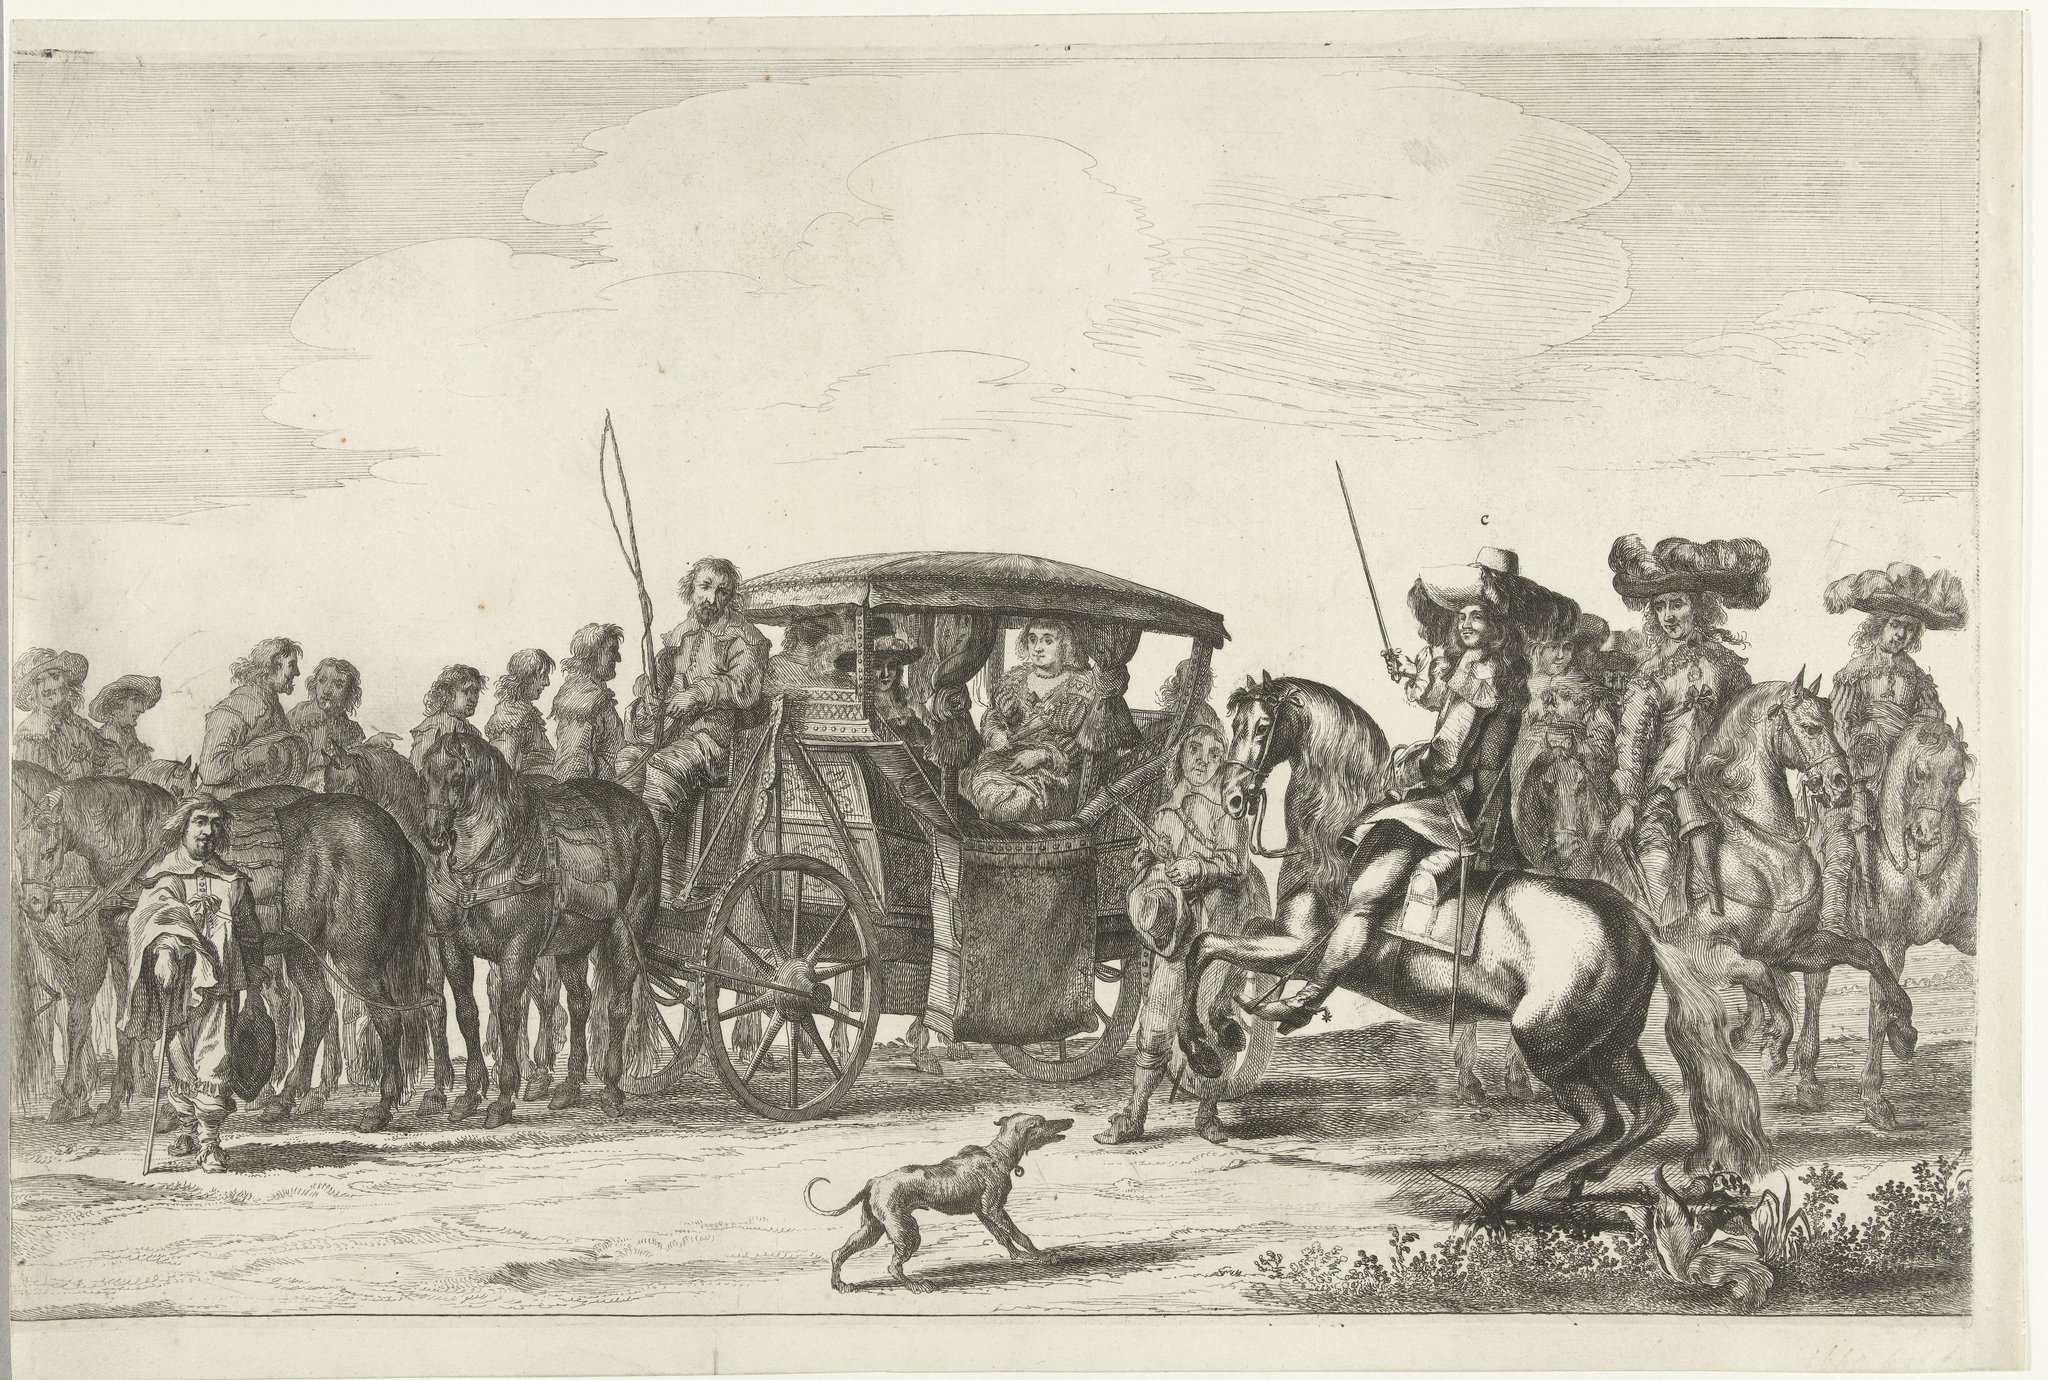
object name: print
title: Intocht van Maria Henrietta Stuart, prinses van Oranje te Amsterdam (plaat 6), 1660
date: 1638-1639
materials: paper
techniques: engraving, etching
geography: northern netherlands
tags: william iii (prince of orange and king of england, scotland, and ireland), amalia of solms-braunfels, london, mary henrietta stuart, triumphal entry and public reception, pageant, 'entrée solennelle', 'joyeuse entrée'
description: Bezoek van de Maria Henrietta Stuart, prinses van Oranje, vergezeld door Amalia van Solms, de jonge prins Willem III en anderen te Amsterdam, 15 juni 1660. Blad met het rijtuig met de prins en prinses en een deel van de stoet met ruiters. De ruiter rechts gemerkt met de letter C. Zesde plaat in een ongemonteerd ensemble bestaande uit een zeven bladen van de stoet.